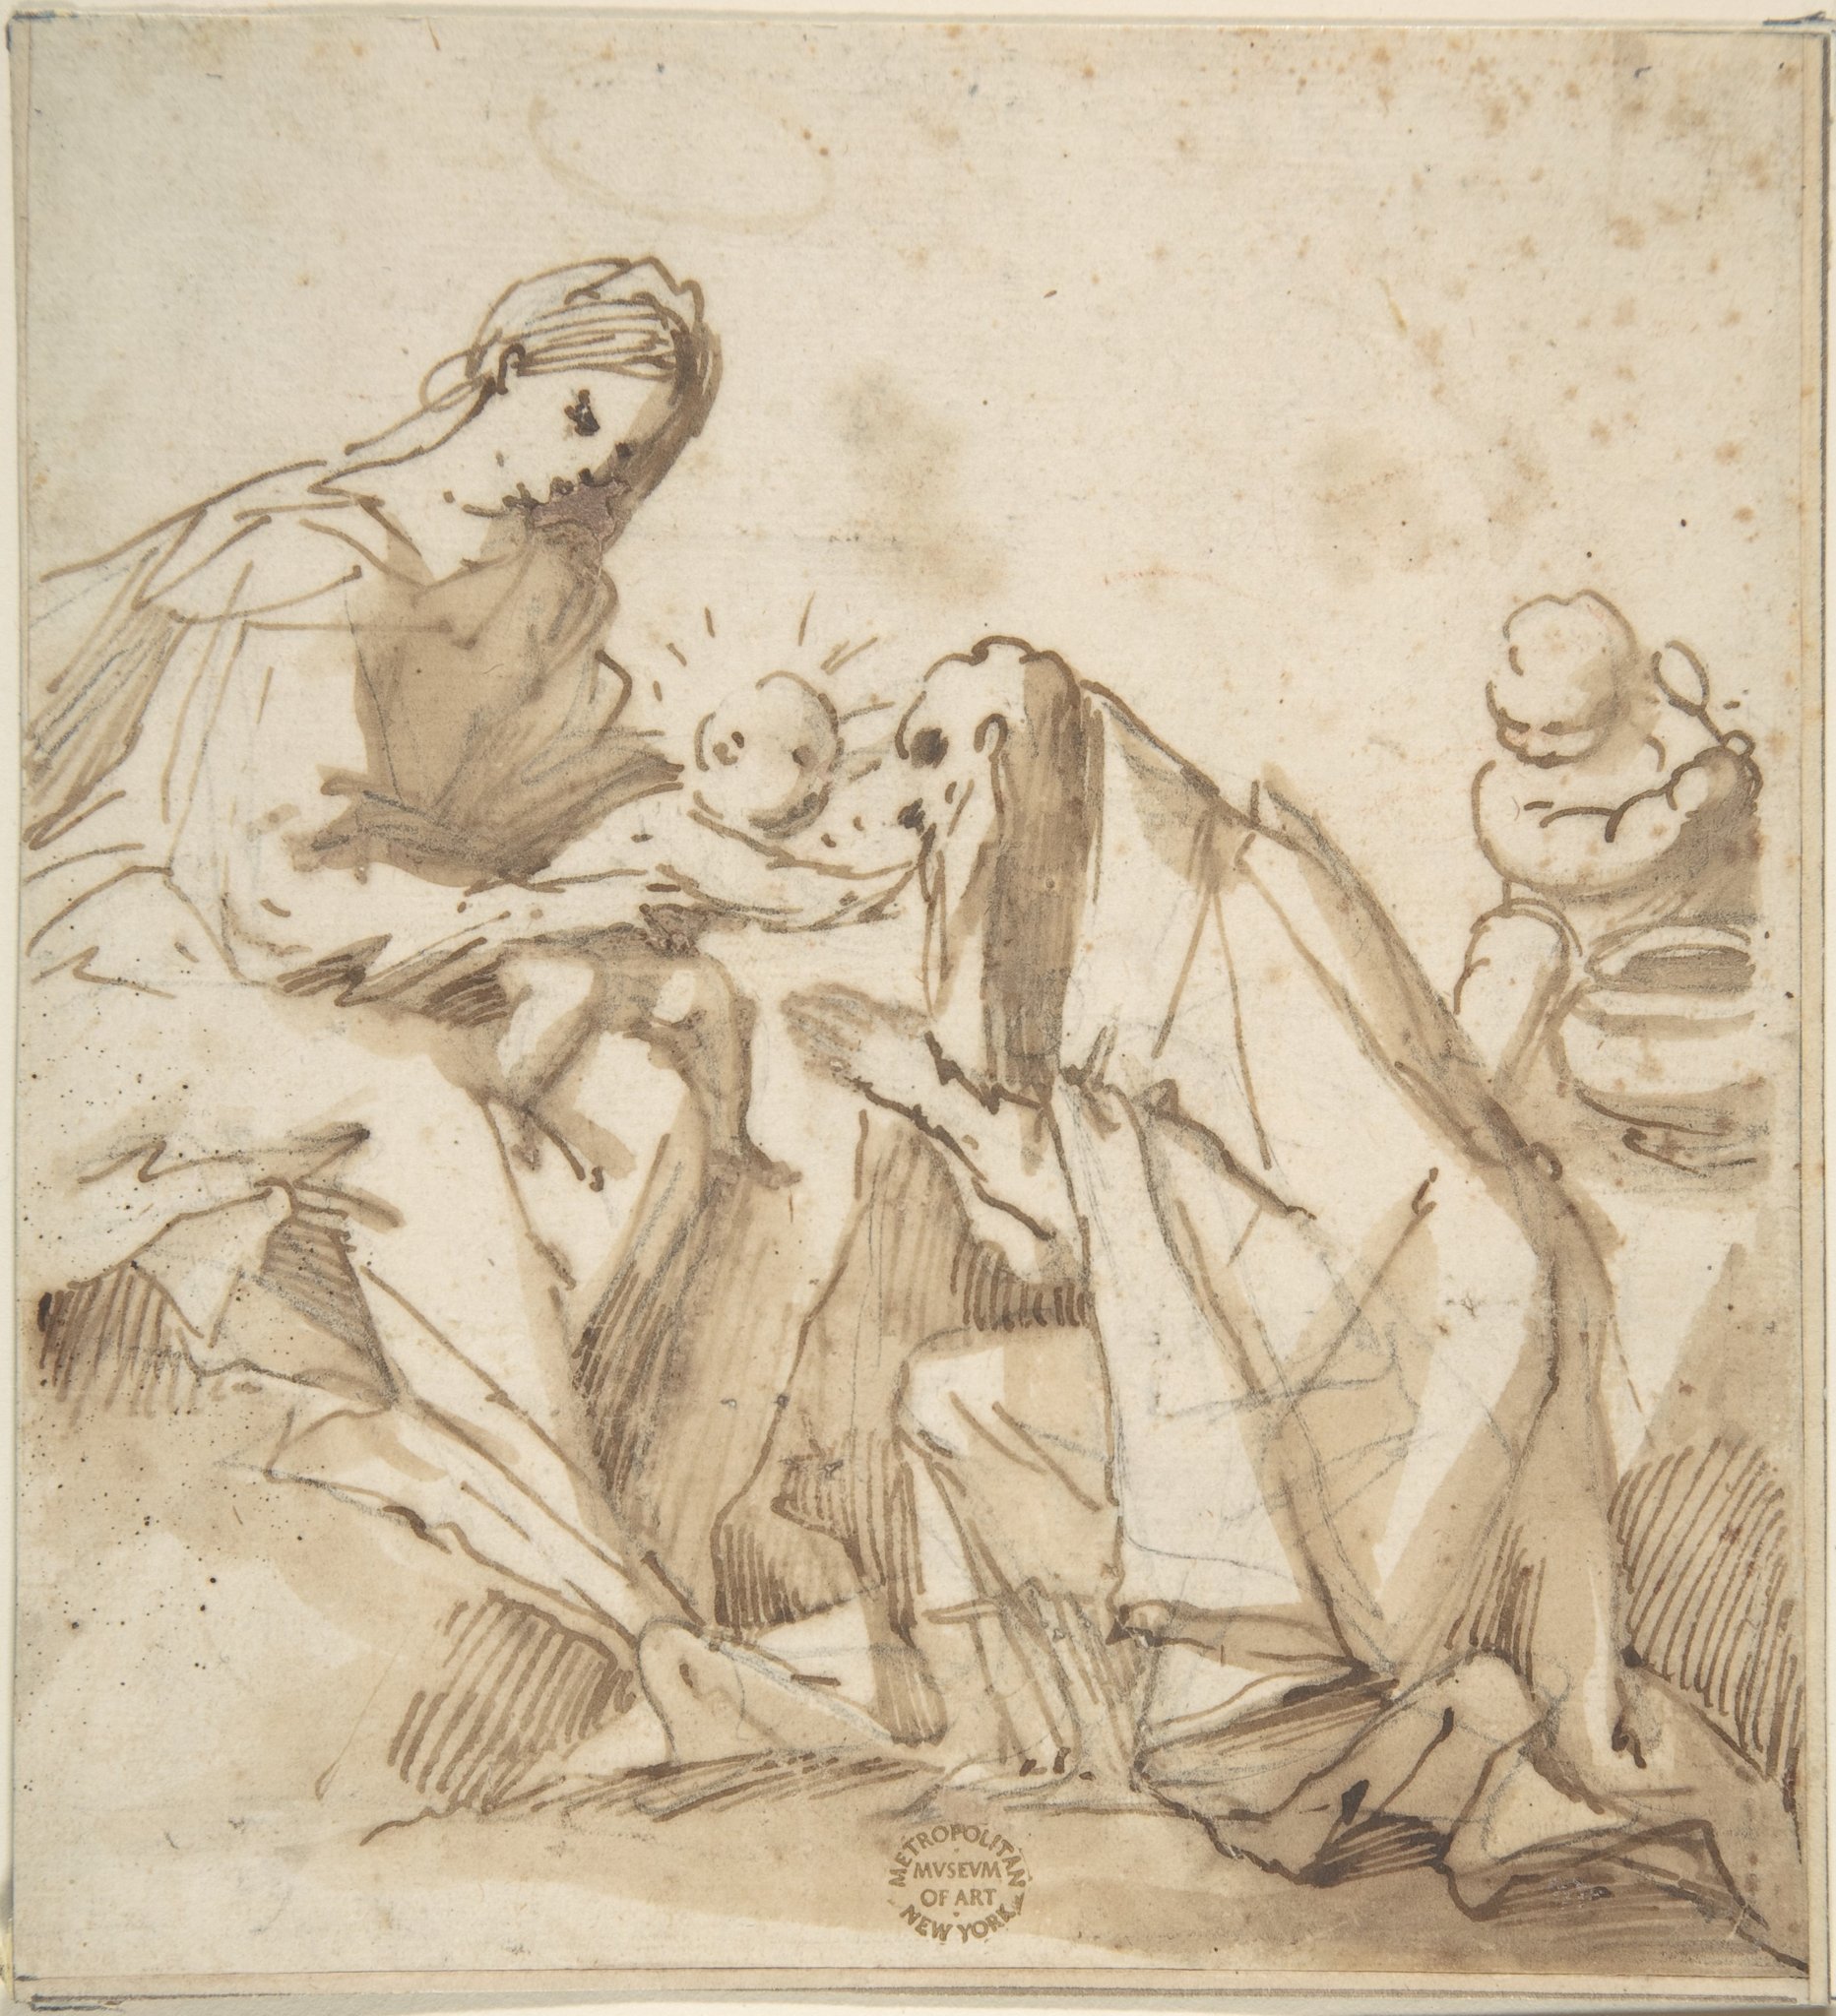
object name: drawing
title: Saint Adoring the Madonna and Child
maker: anonymous, italian, roman-bolognese, 17th century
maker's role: artist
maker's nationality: italian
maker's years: 1600-1700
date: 1601-1700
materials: charcoal, ink, paper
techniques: brush, pen, wash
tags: madonna and child,saints